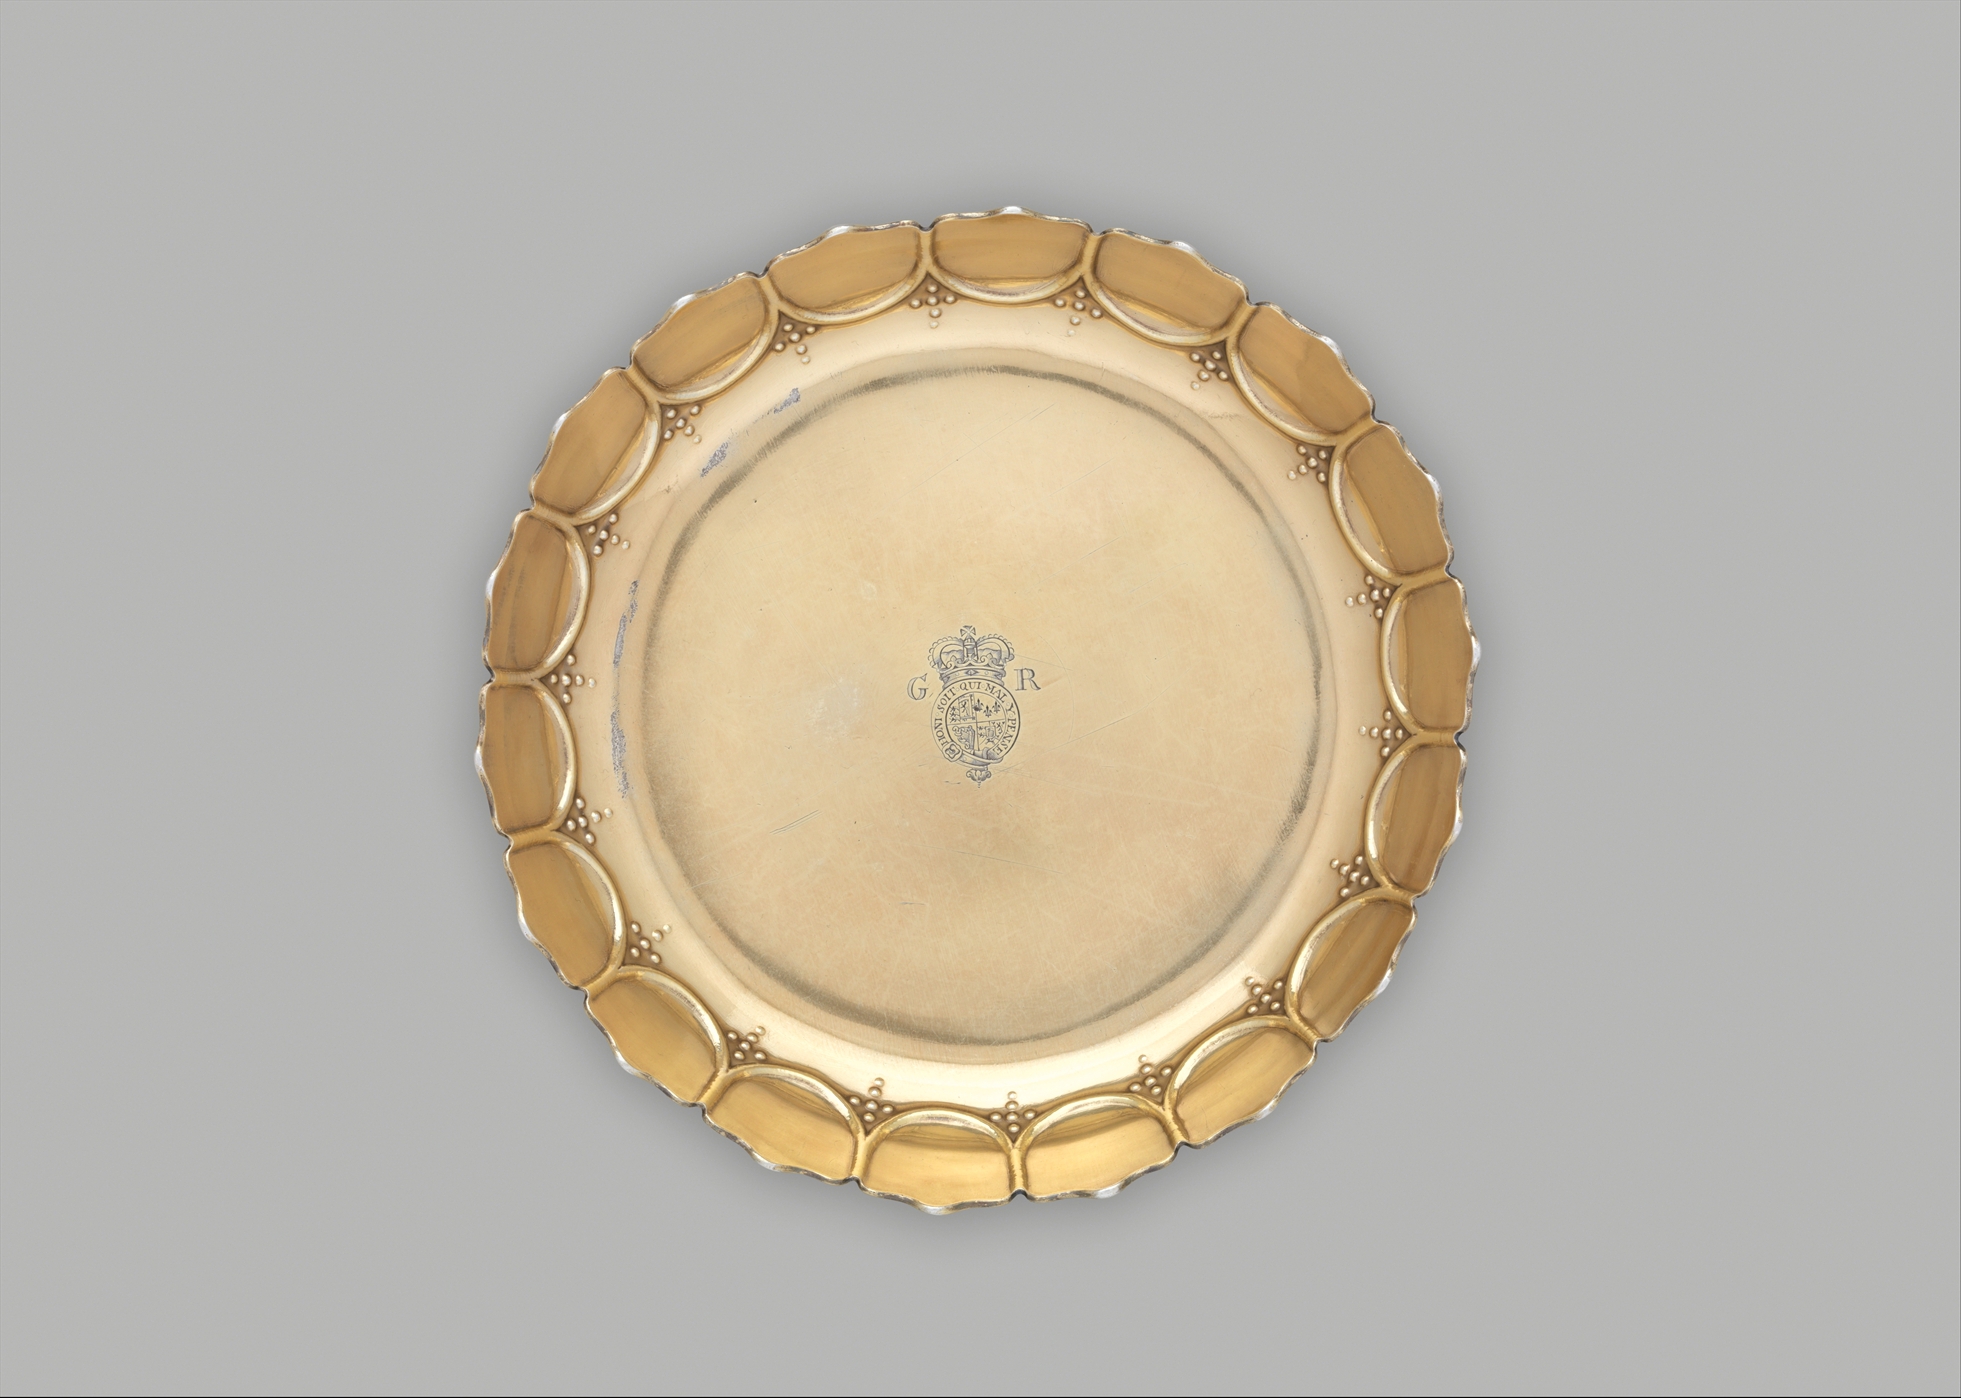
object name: dish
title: Dish (one of a pair) (part of a set)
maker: lewis mettayer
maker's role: maker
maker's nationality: british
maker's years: 1640-1740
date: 1714-1715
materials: gilt silver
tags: coat of arms